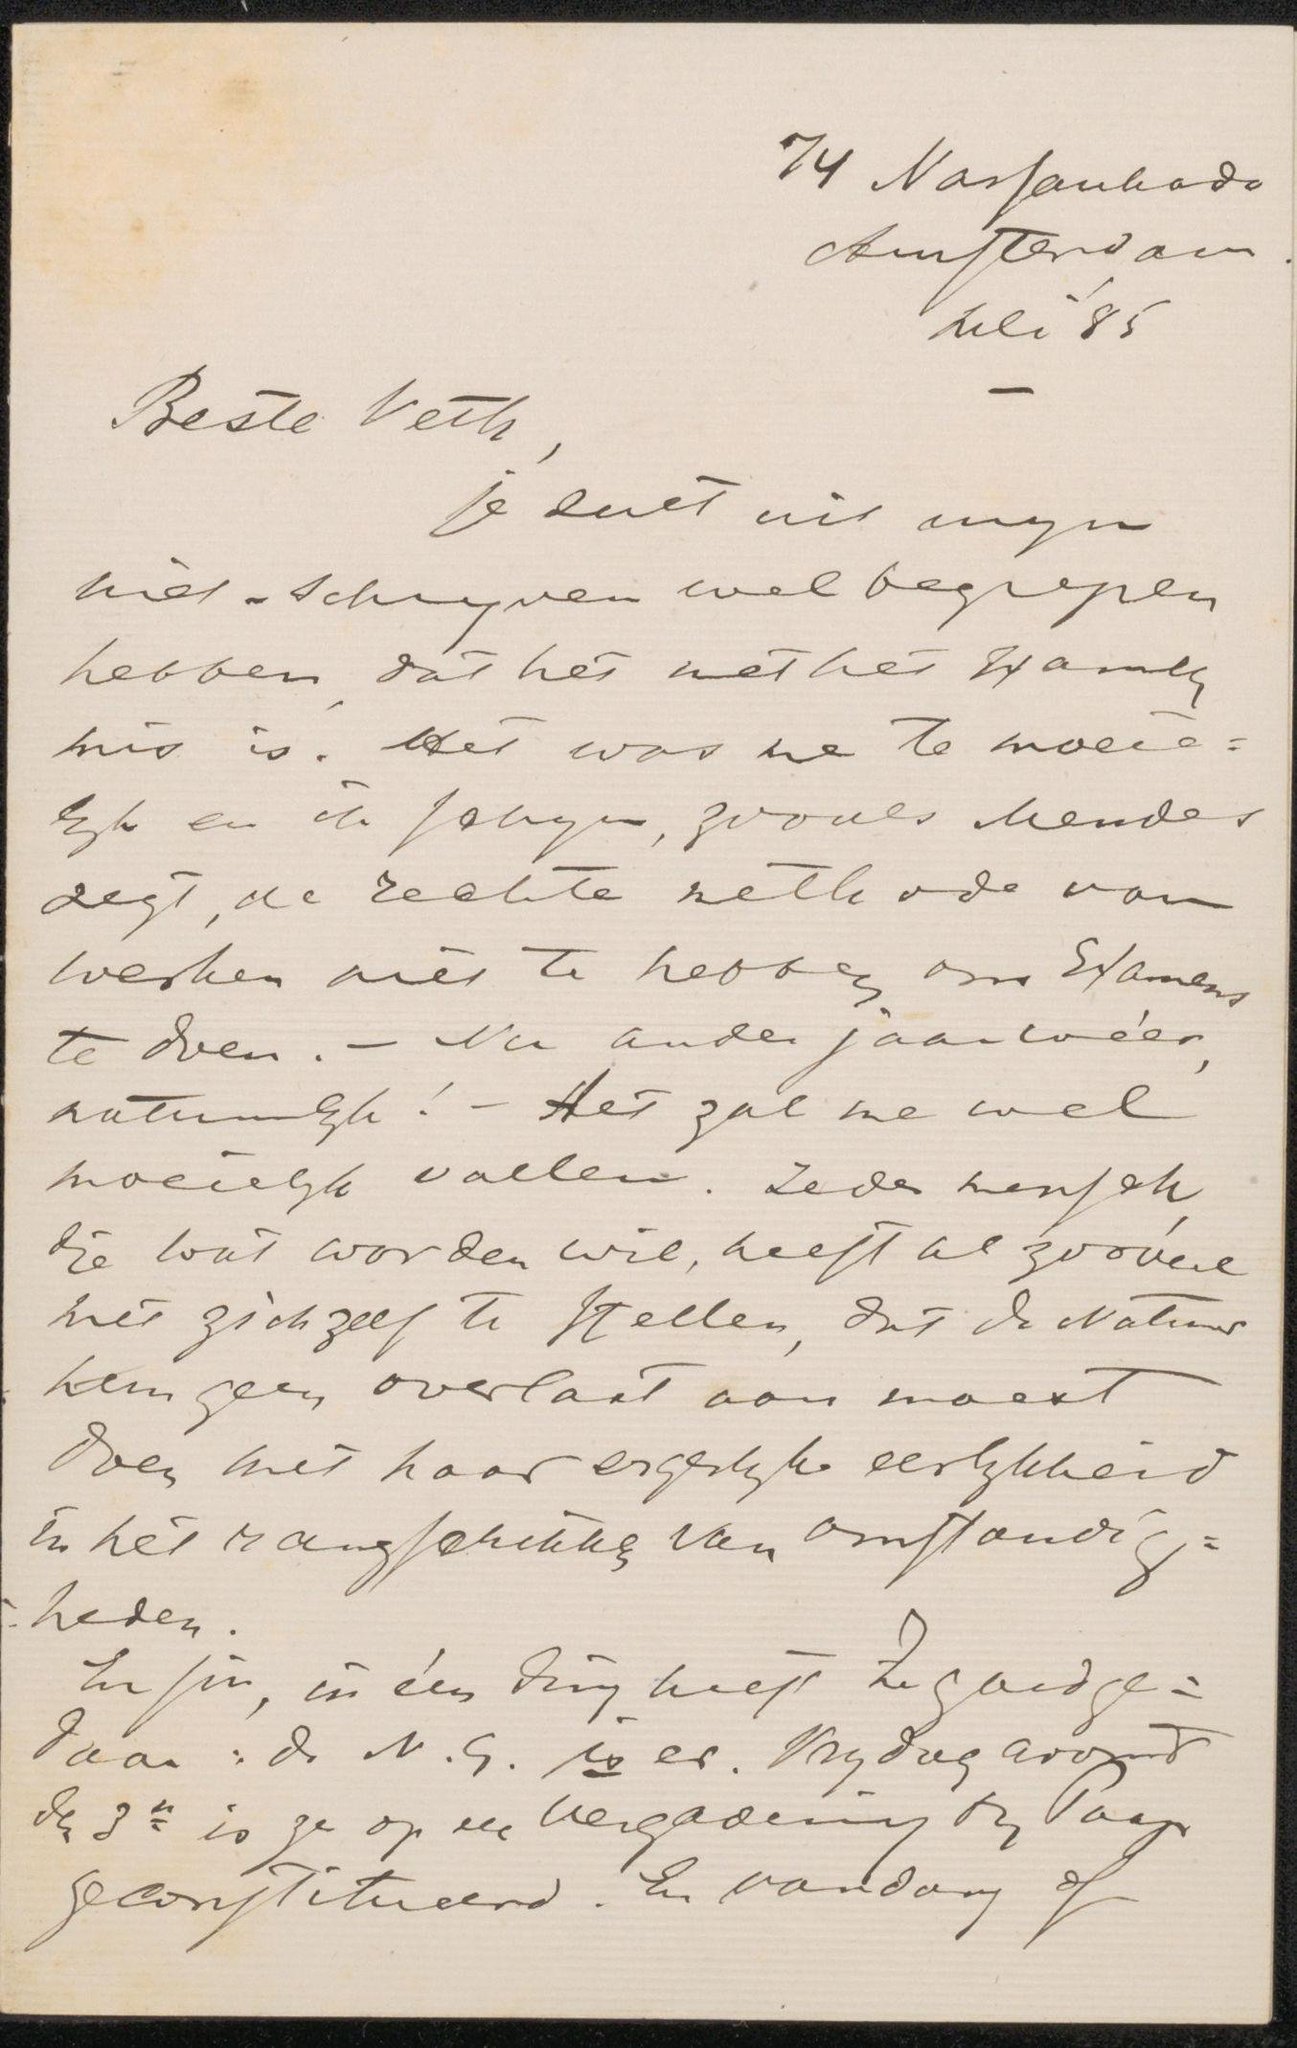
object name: letter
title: Brief aan Jan Veth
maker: albert verwey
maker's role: criticus, dichter, essayist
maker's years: 1865-1937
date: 1805-1885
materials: ink, paper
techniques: pen, writing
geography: amsterdam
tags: painter, print maker, draughtsman, designer, jan veth, the hague, willem kloos, dordrecht, amsterdam, chap van deventer, frederik van eeden, zeist, haarlem, frans netscher, passions, emotions, affections, literature ~ arts, workshop, studio of the artist (in general), brabant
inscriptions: collector's mark: ‘RPK’